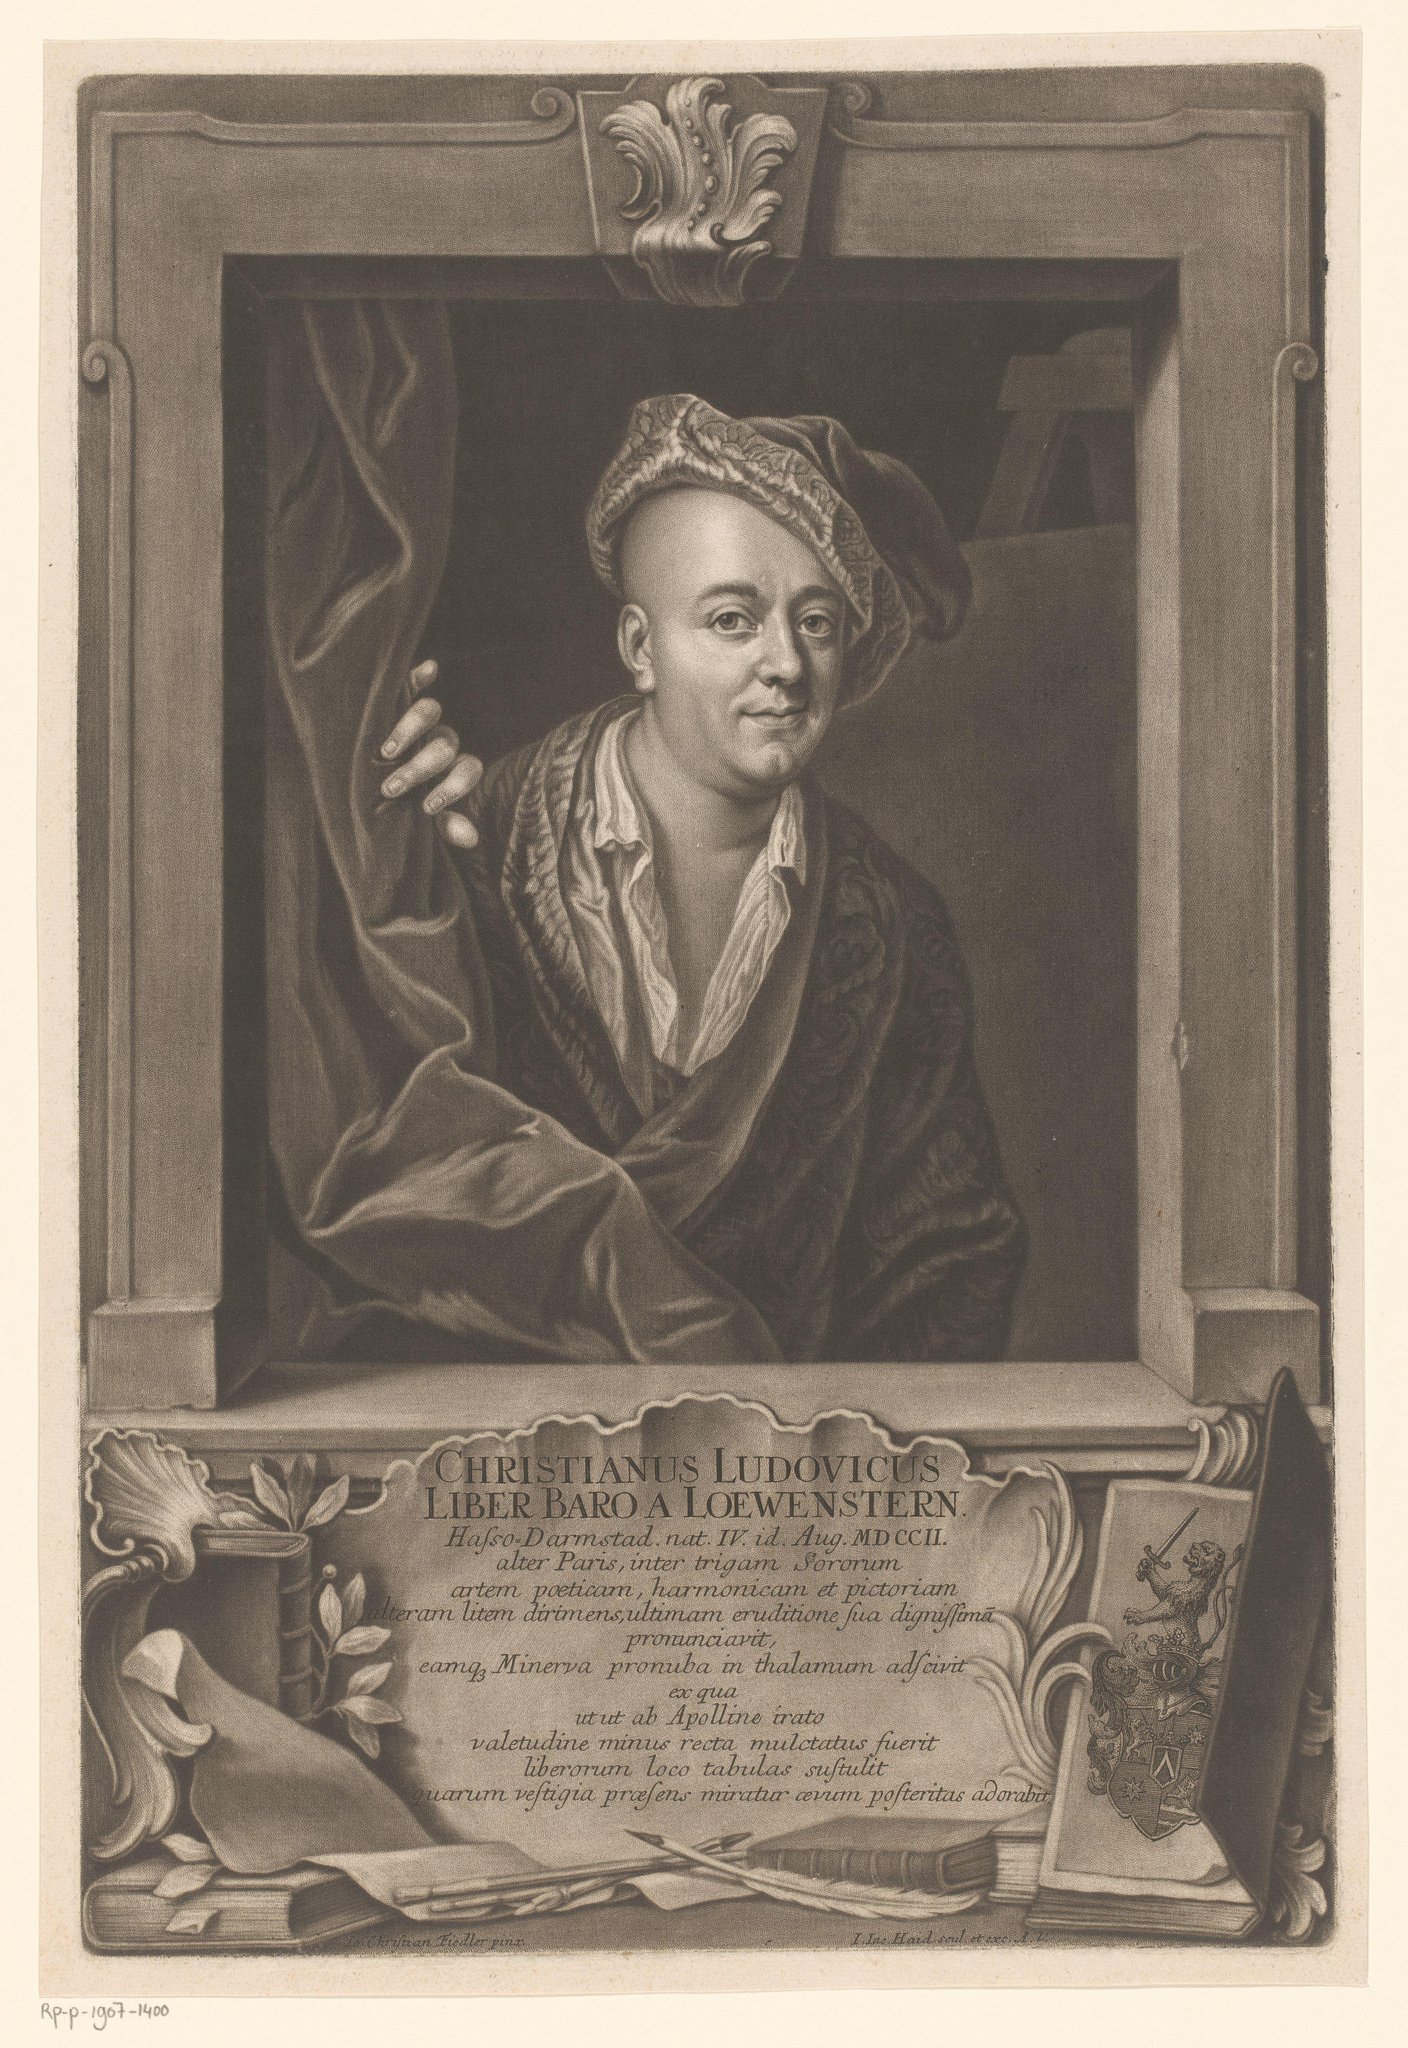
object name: print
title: Portret van Christian Ludwig von Löwenstern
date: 1714-1754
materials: paper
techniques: etching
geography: augsburg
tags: painter, rocaille ornament, writing tools, historical persons, portrait, self-portrait of painter, tools, implements of painter, armorial bearing, heraldry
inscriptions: collector's mark: Lugt 2228